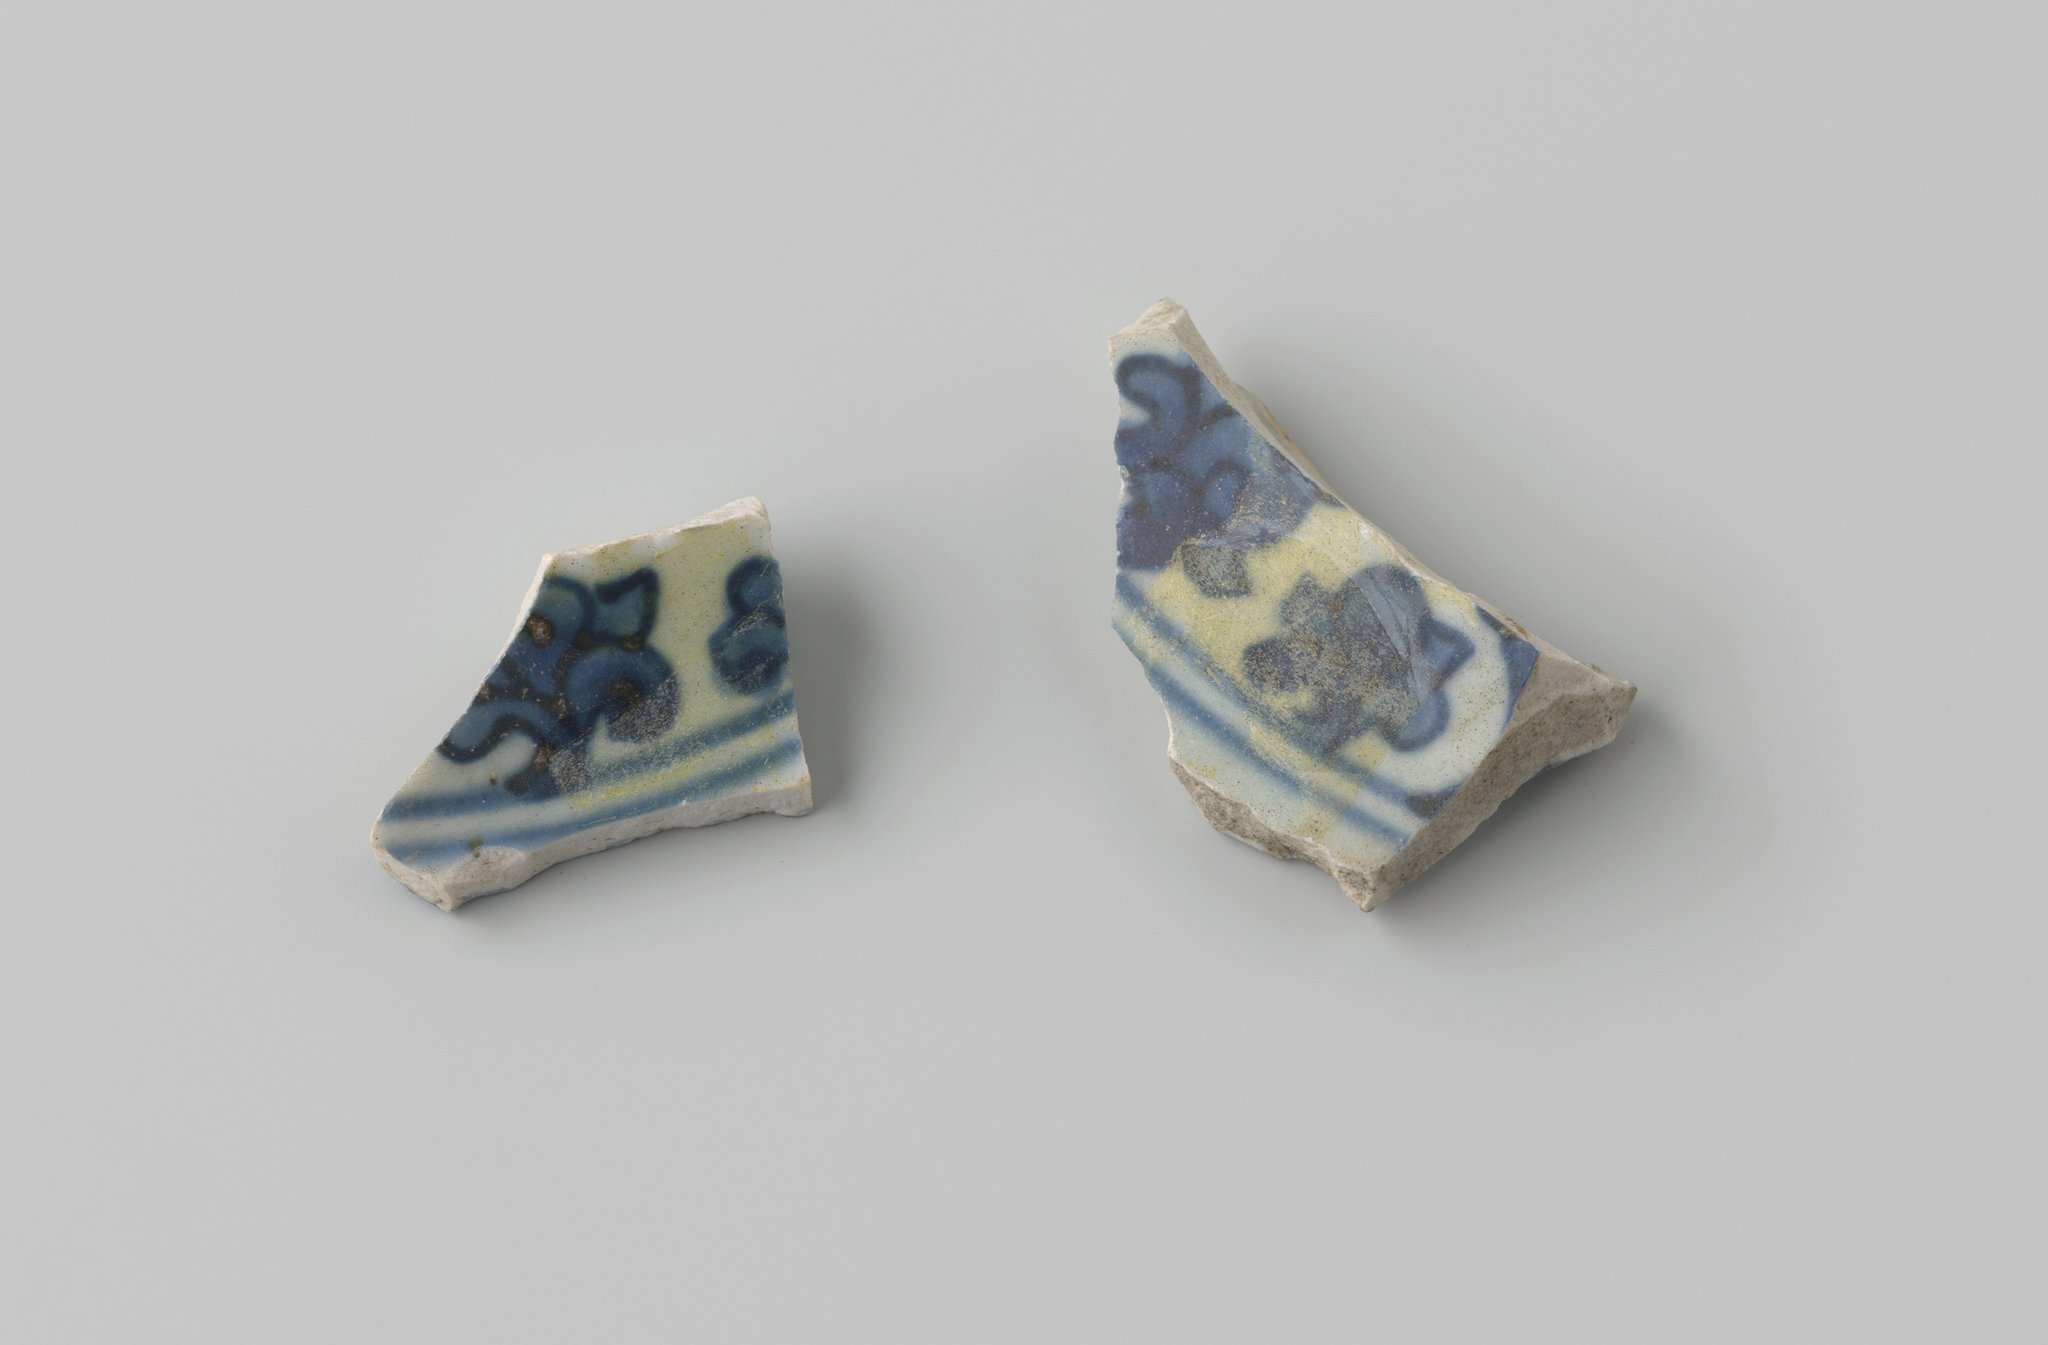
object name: bowl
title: Scherven van kommen uit V.O.C.-schip de 'Witte Leeuw'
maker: Anonymous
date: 1613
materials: porcelain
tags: verenigde oostindische compagnie, sint-helena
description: Scherven van kommen uit V.O.C.-schip de 'Witte Leeuw'.